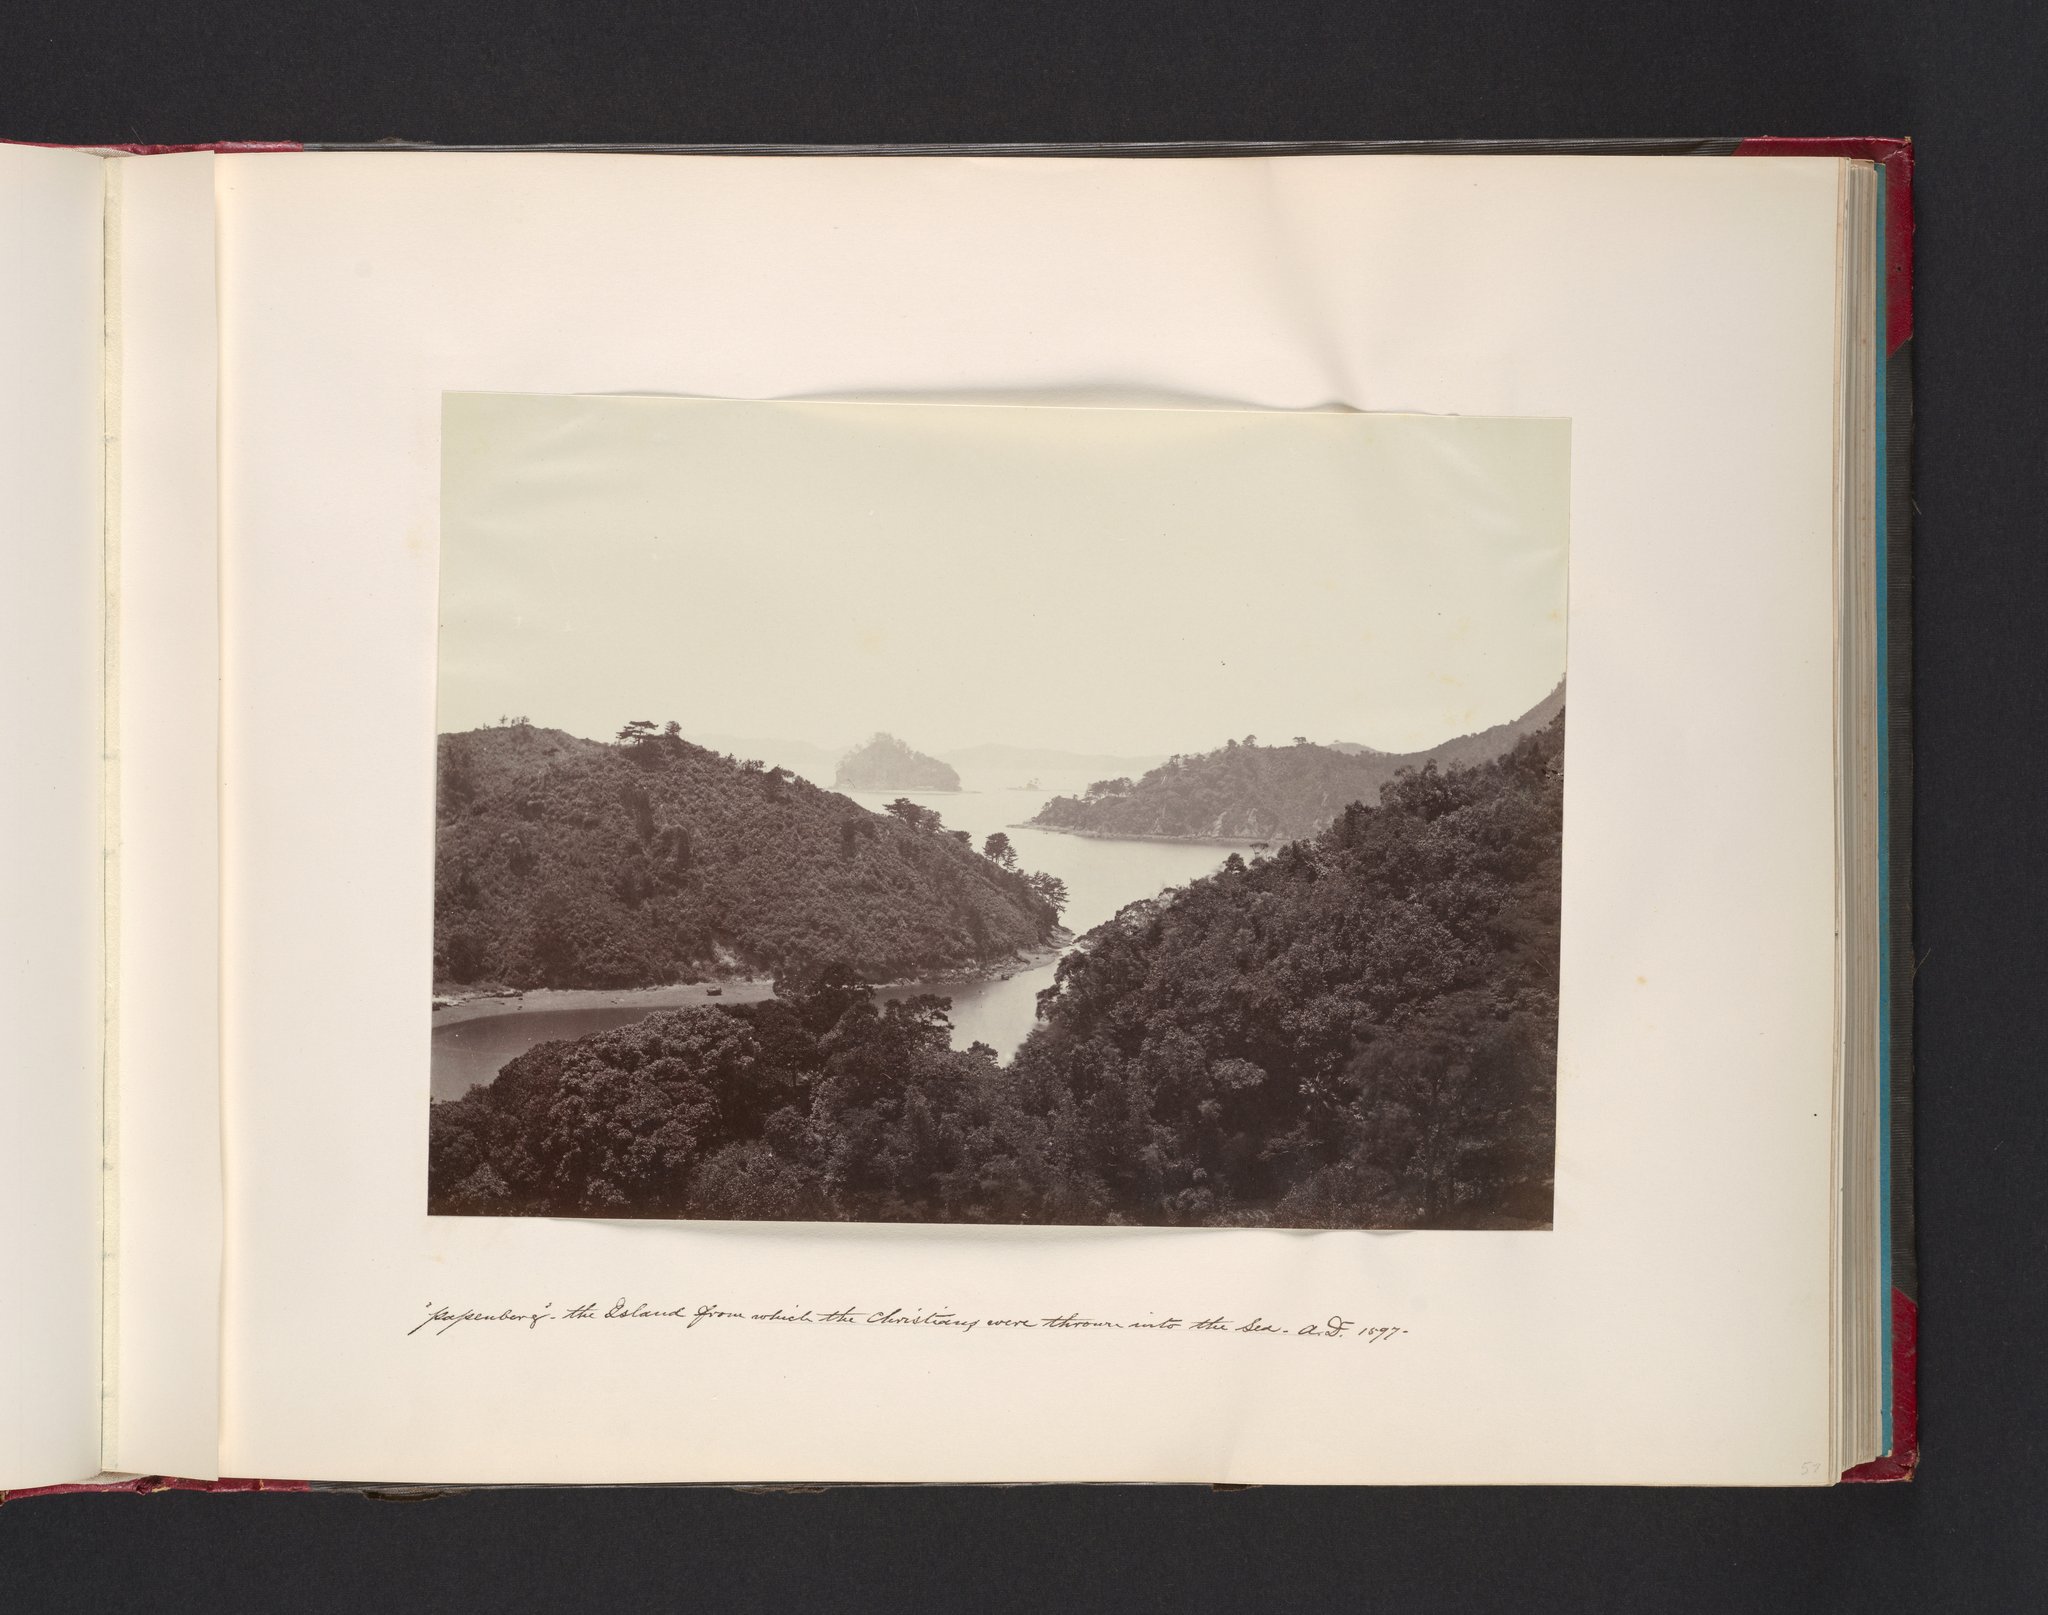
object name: photograph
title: Papenberg, the Island from Which the Christians were Thrown into the Sea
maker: john thomson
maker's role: artist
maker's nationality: british, scottish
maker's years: 1837-1921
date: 1865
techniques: albumen silver print, glass negative